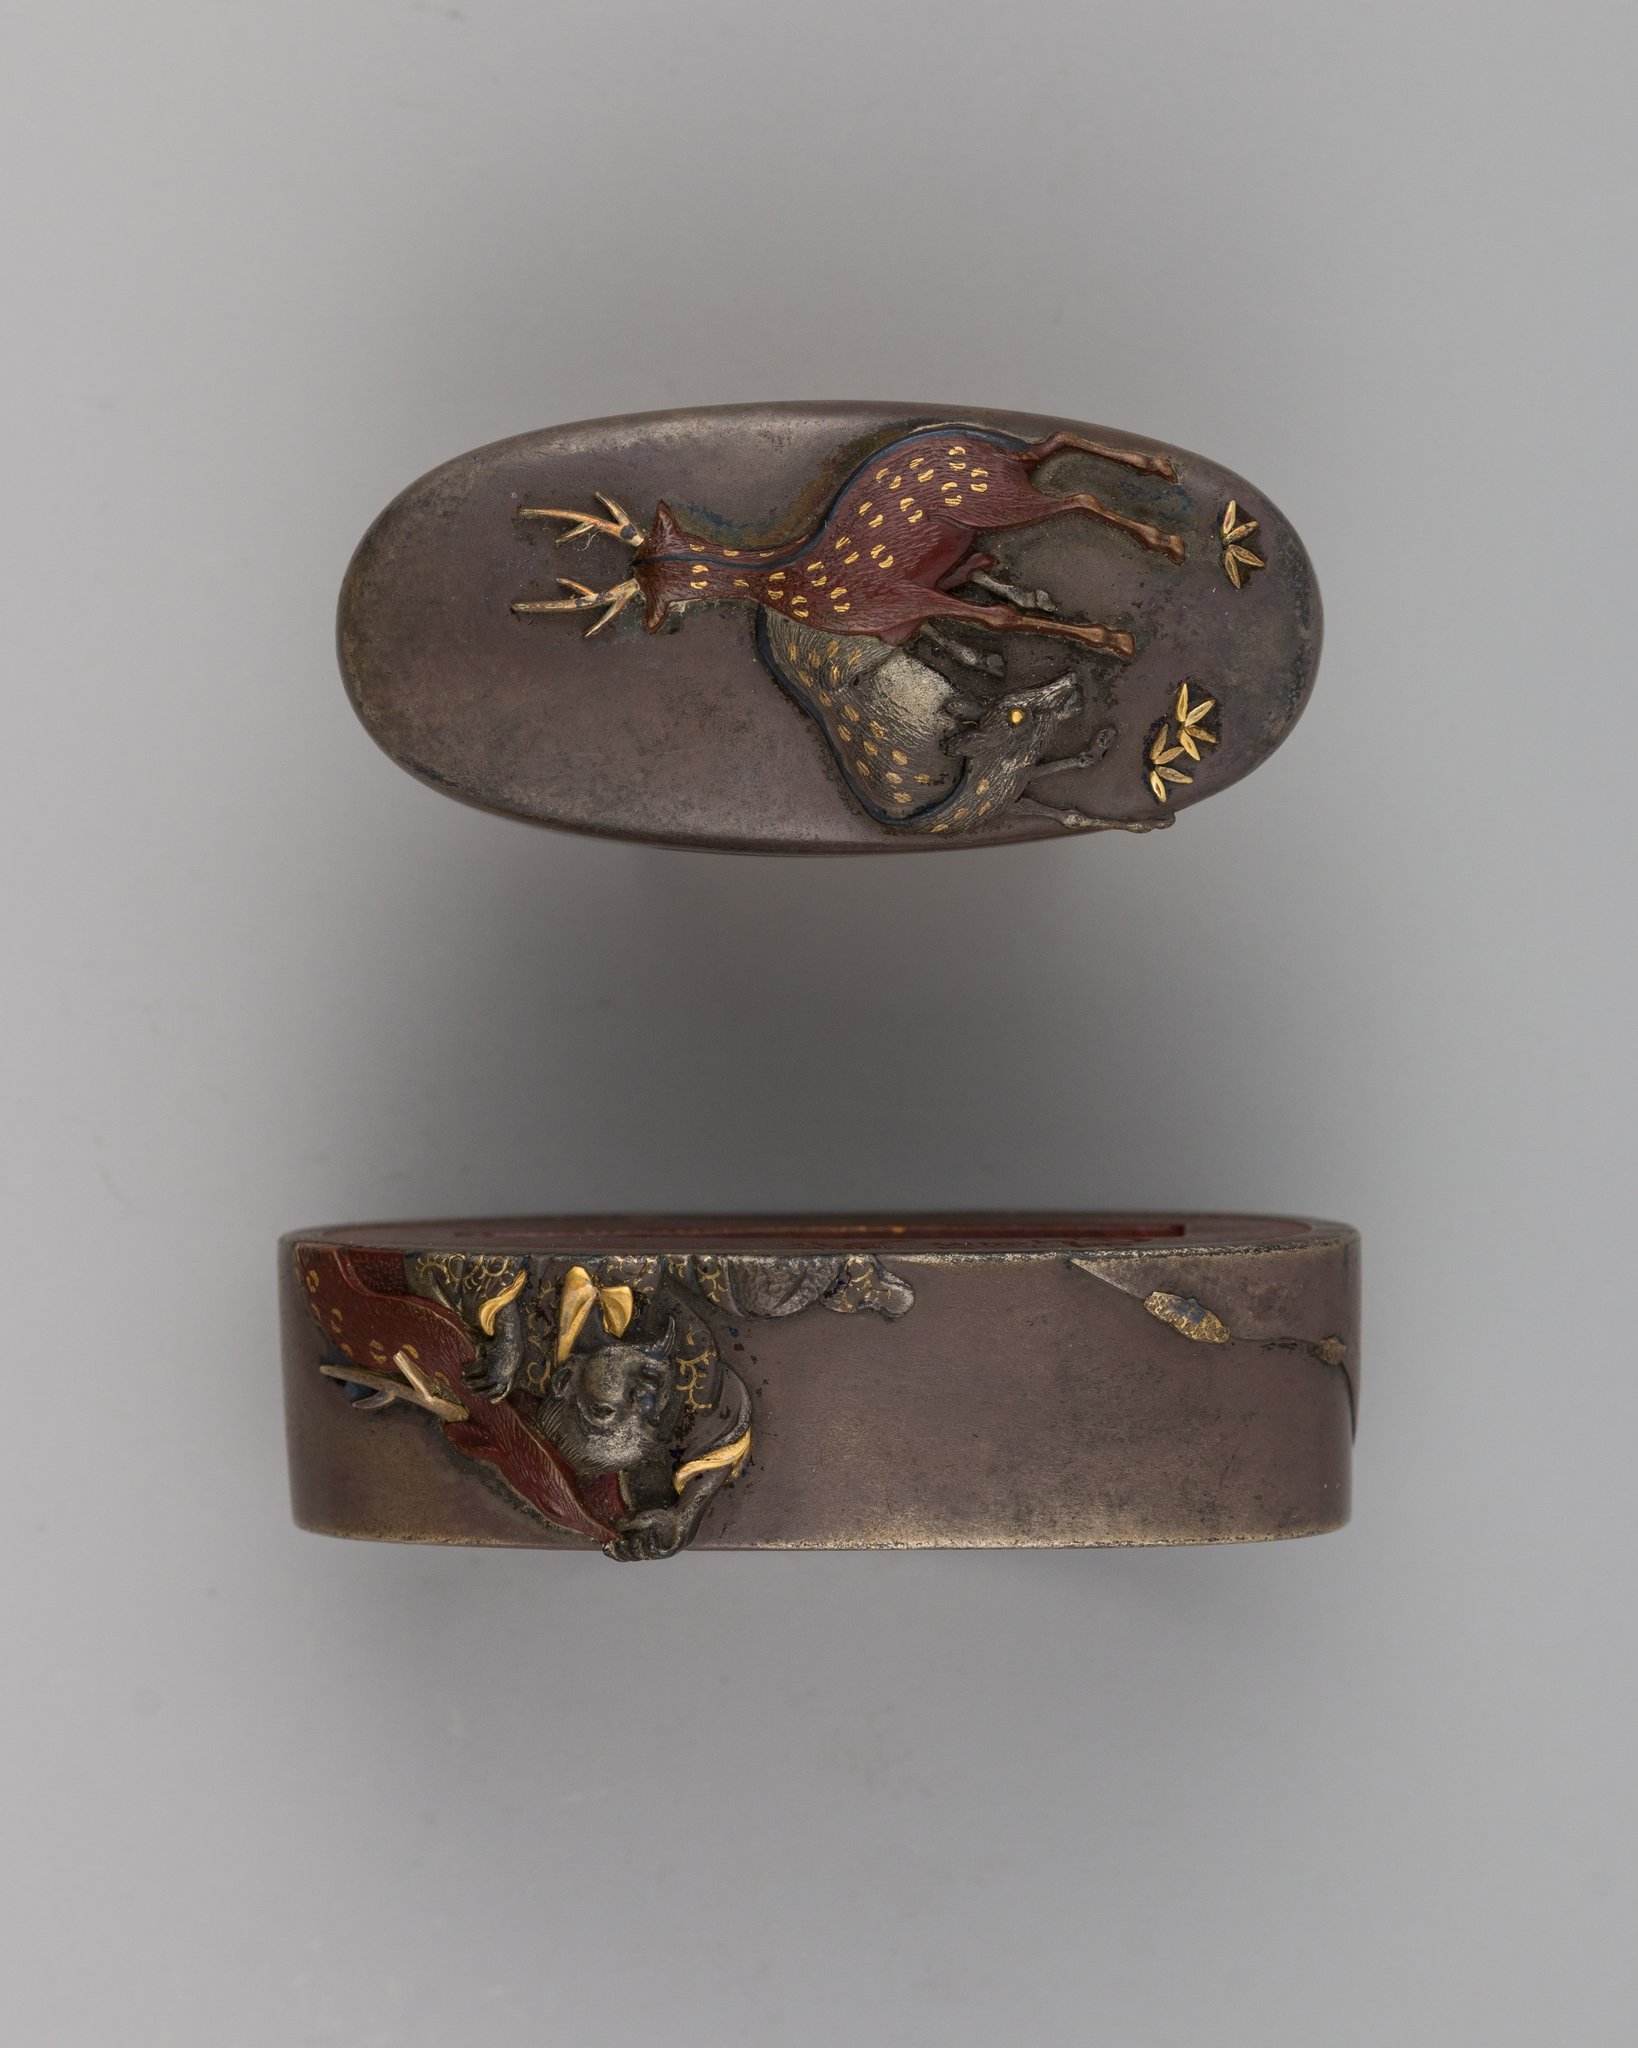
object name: sword hilt collar and pommel fuchigashira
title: Sword-Hilt Collar and Pommel (Fuchigashira)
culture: japanese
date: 1615-1868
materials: copper, silver alloy, gold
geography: japan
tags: men,deer